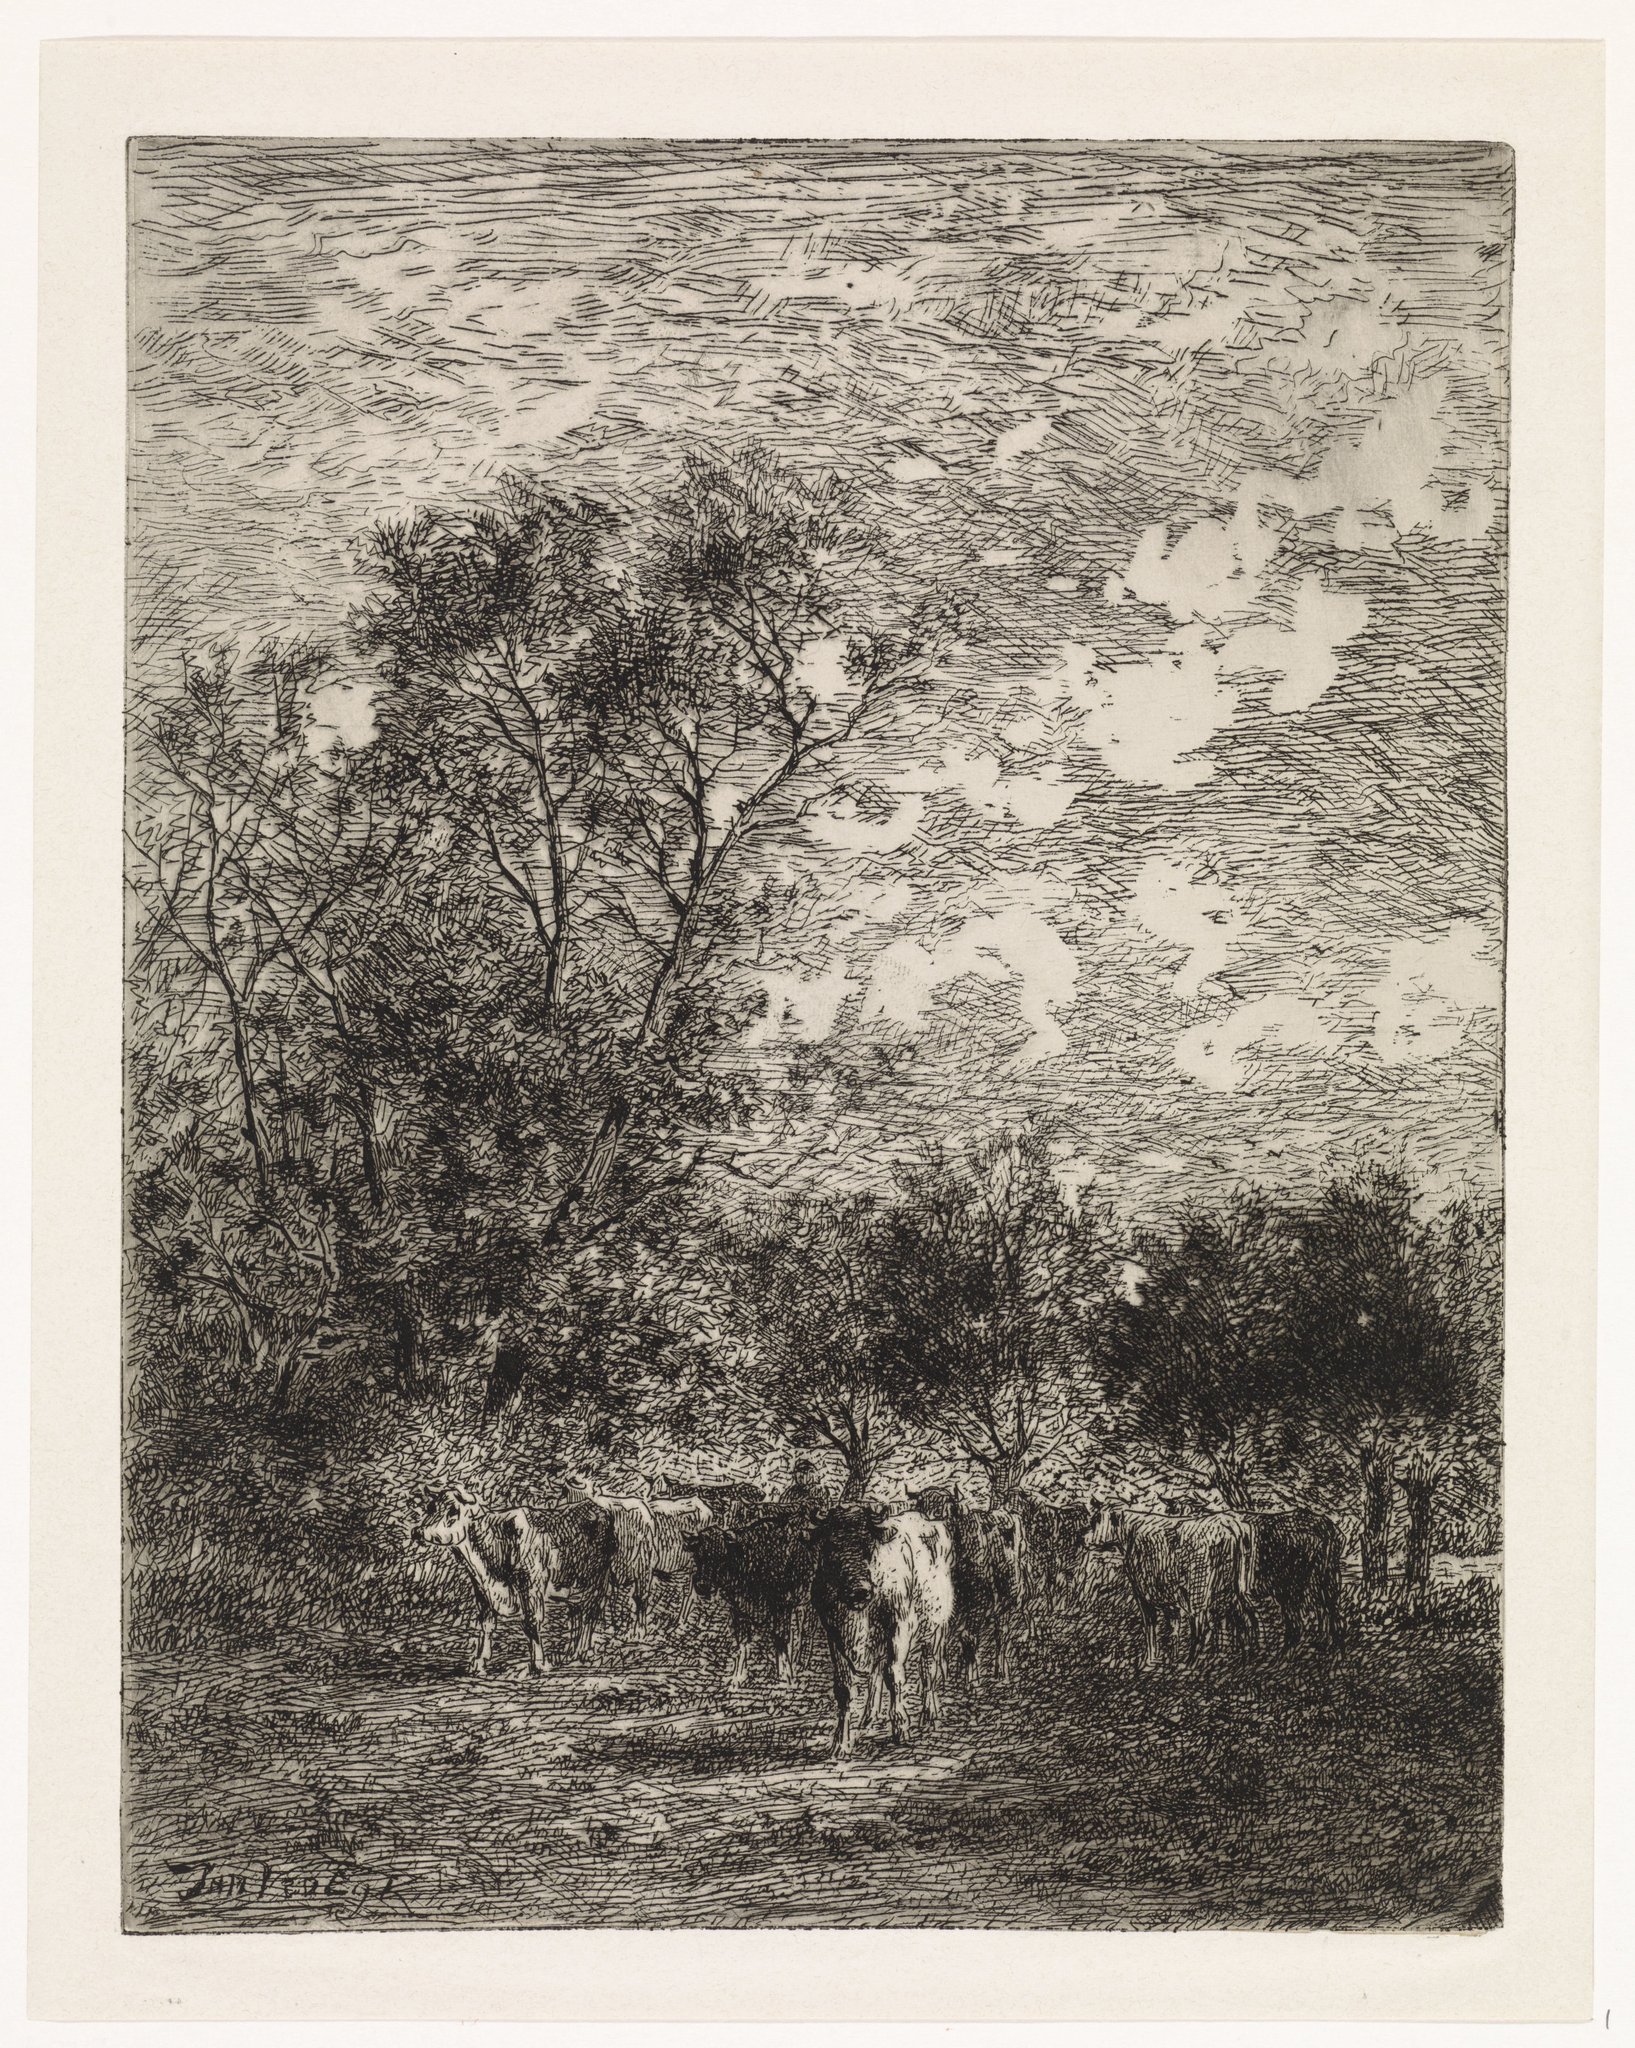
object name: print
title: Koeien op een open plek, bij wilgen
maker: jan vrolijk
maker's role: draughtsman, painter, print maker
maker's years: 1846-1894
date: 1860-1892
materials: paper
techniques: etching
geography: the hague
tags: cow, trees: willow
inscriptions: collector's mark: Lugt 2228